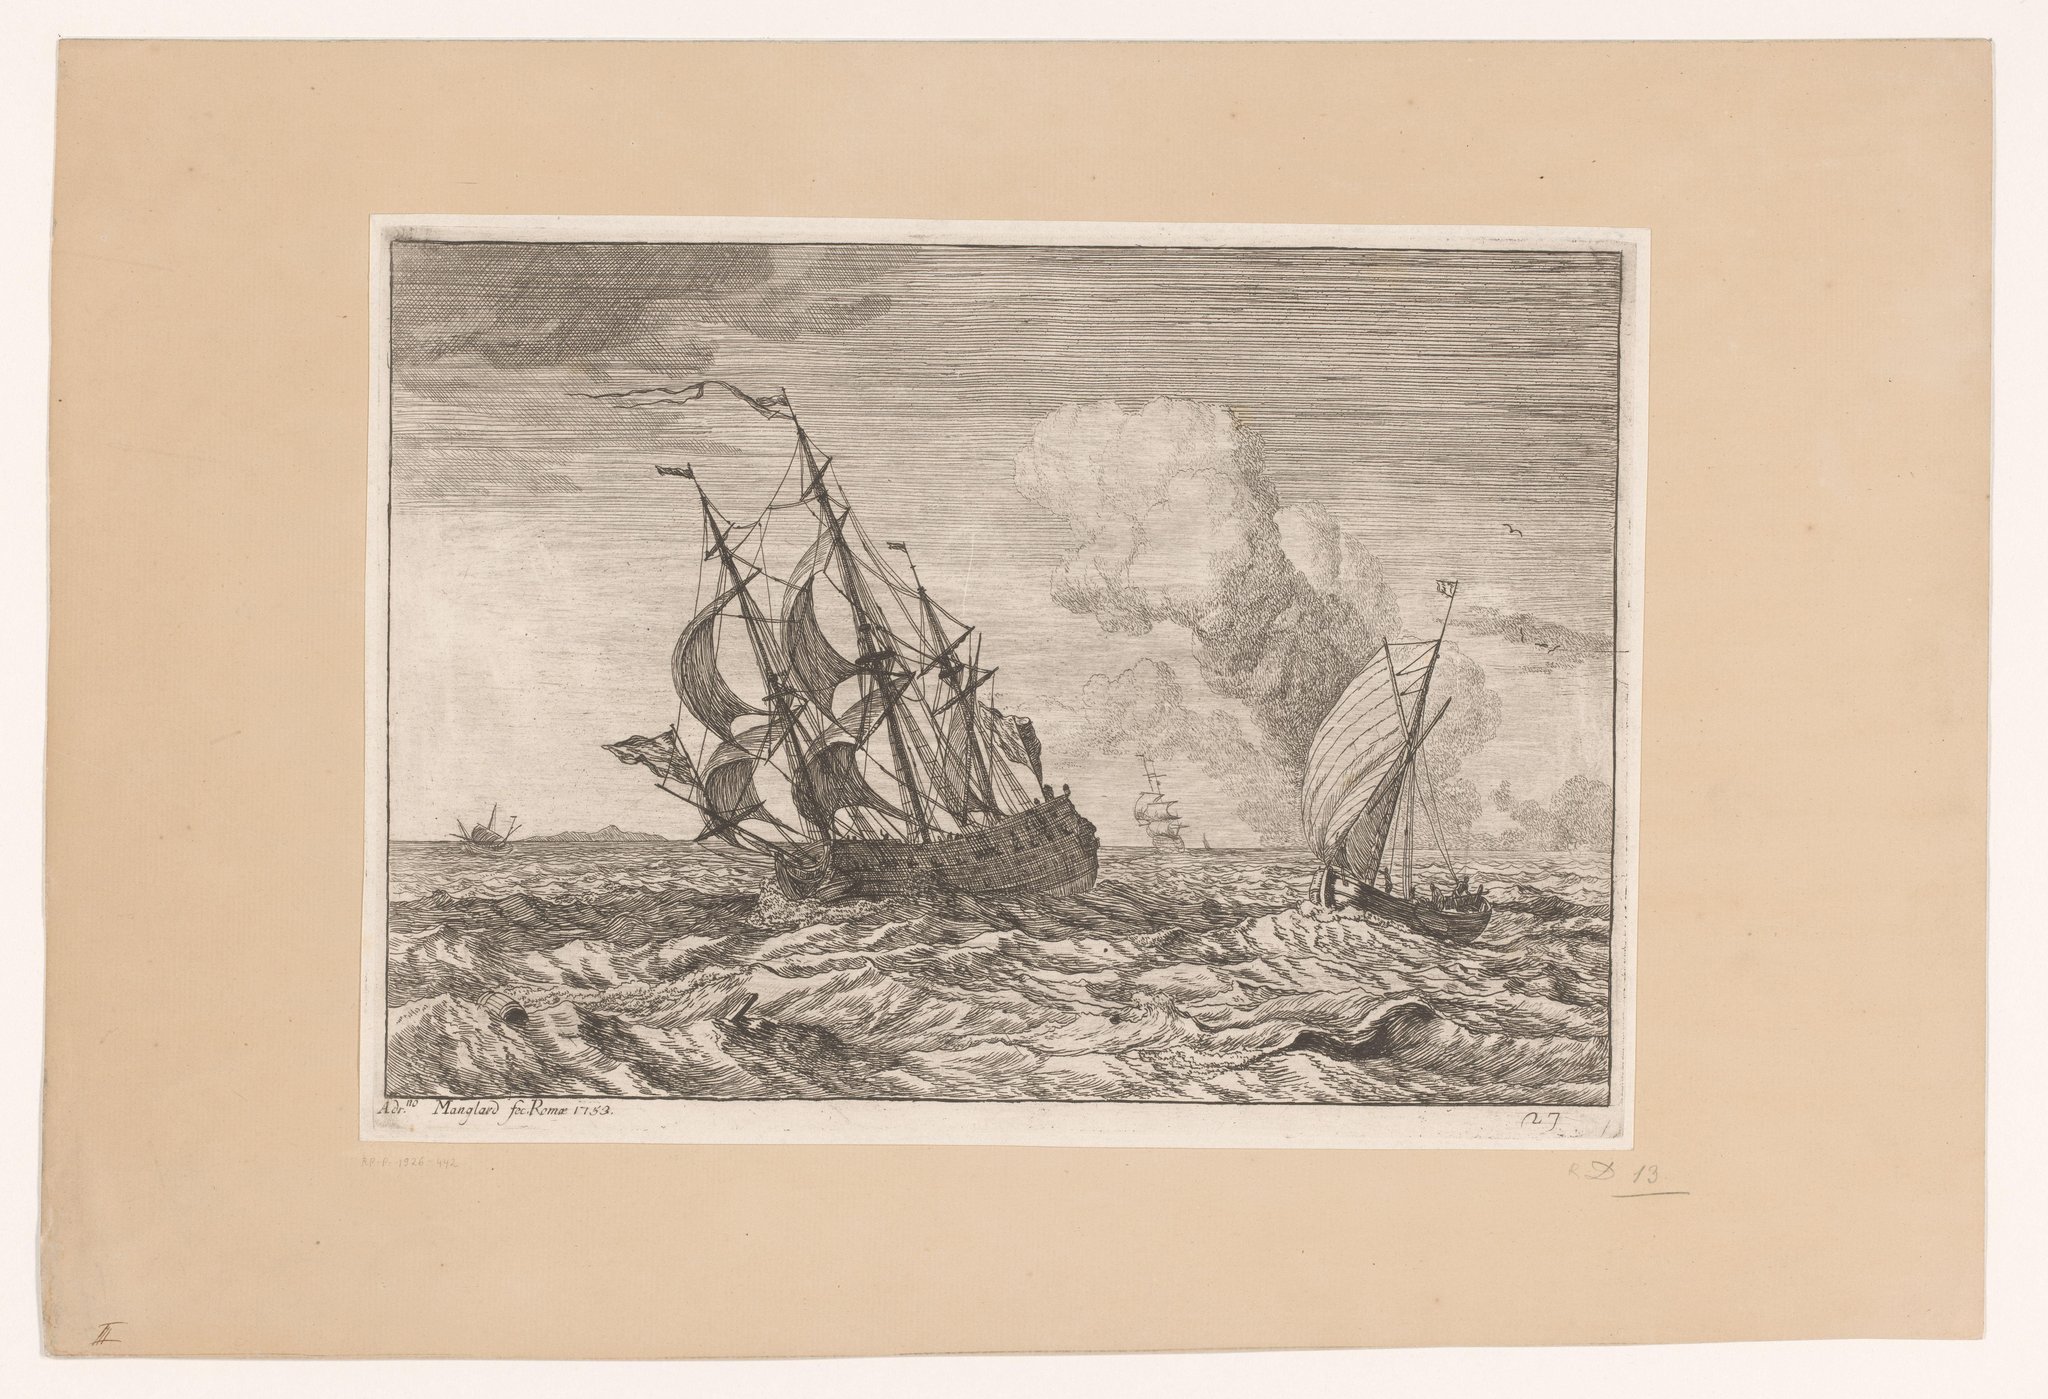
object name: print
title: Zeegezicht met schepen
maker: adrien manglard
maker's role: draughtsman, print maker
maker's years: 1695-1760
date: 1753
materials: paper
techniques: etching, intaglio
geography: rome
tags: ships (in general), sea (seascape)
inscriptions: collector's mark: Lugt 2166